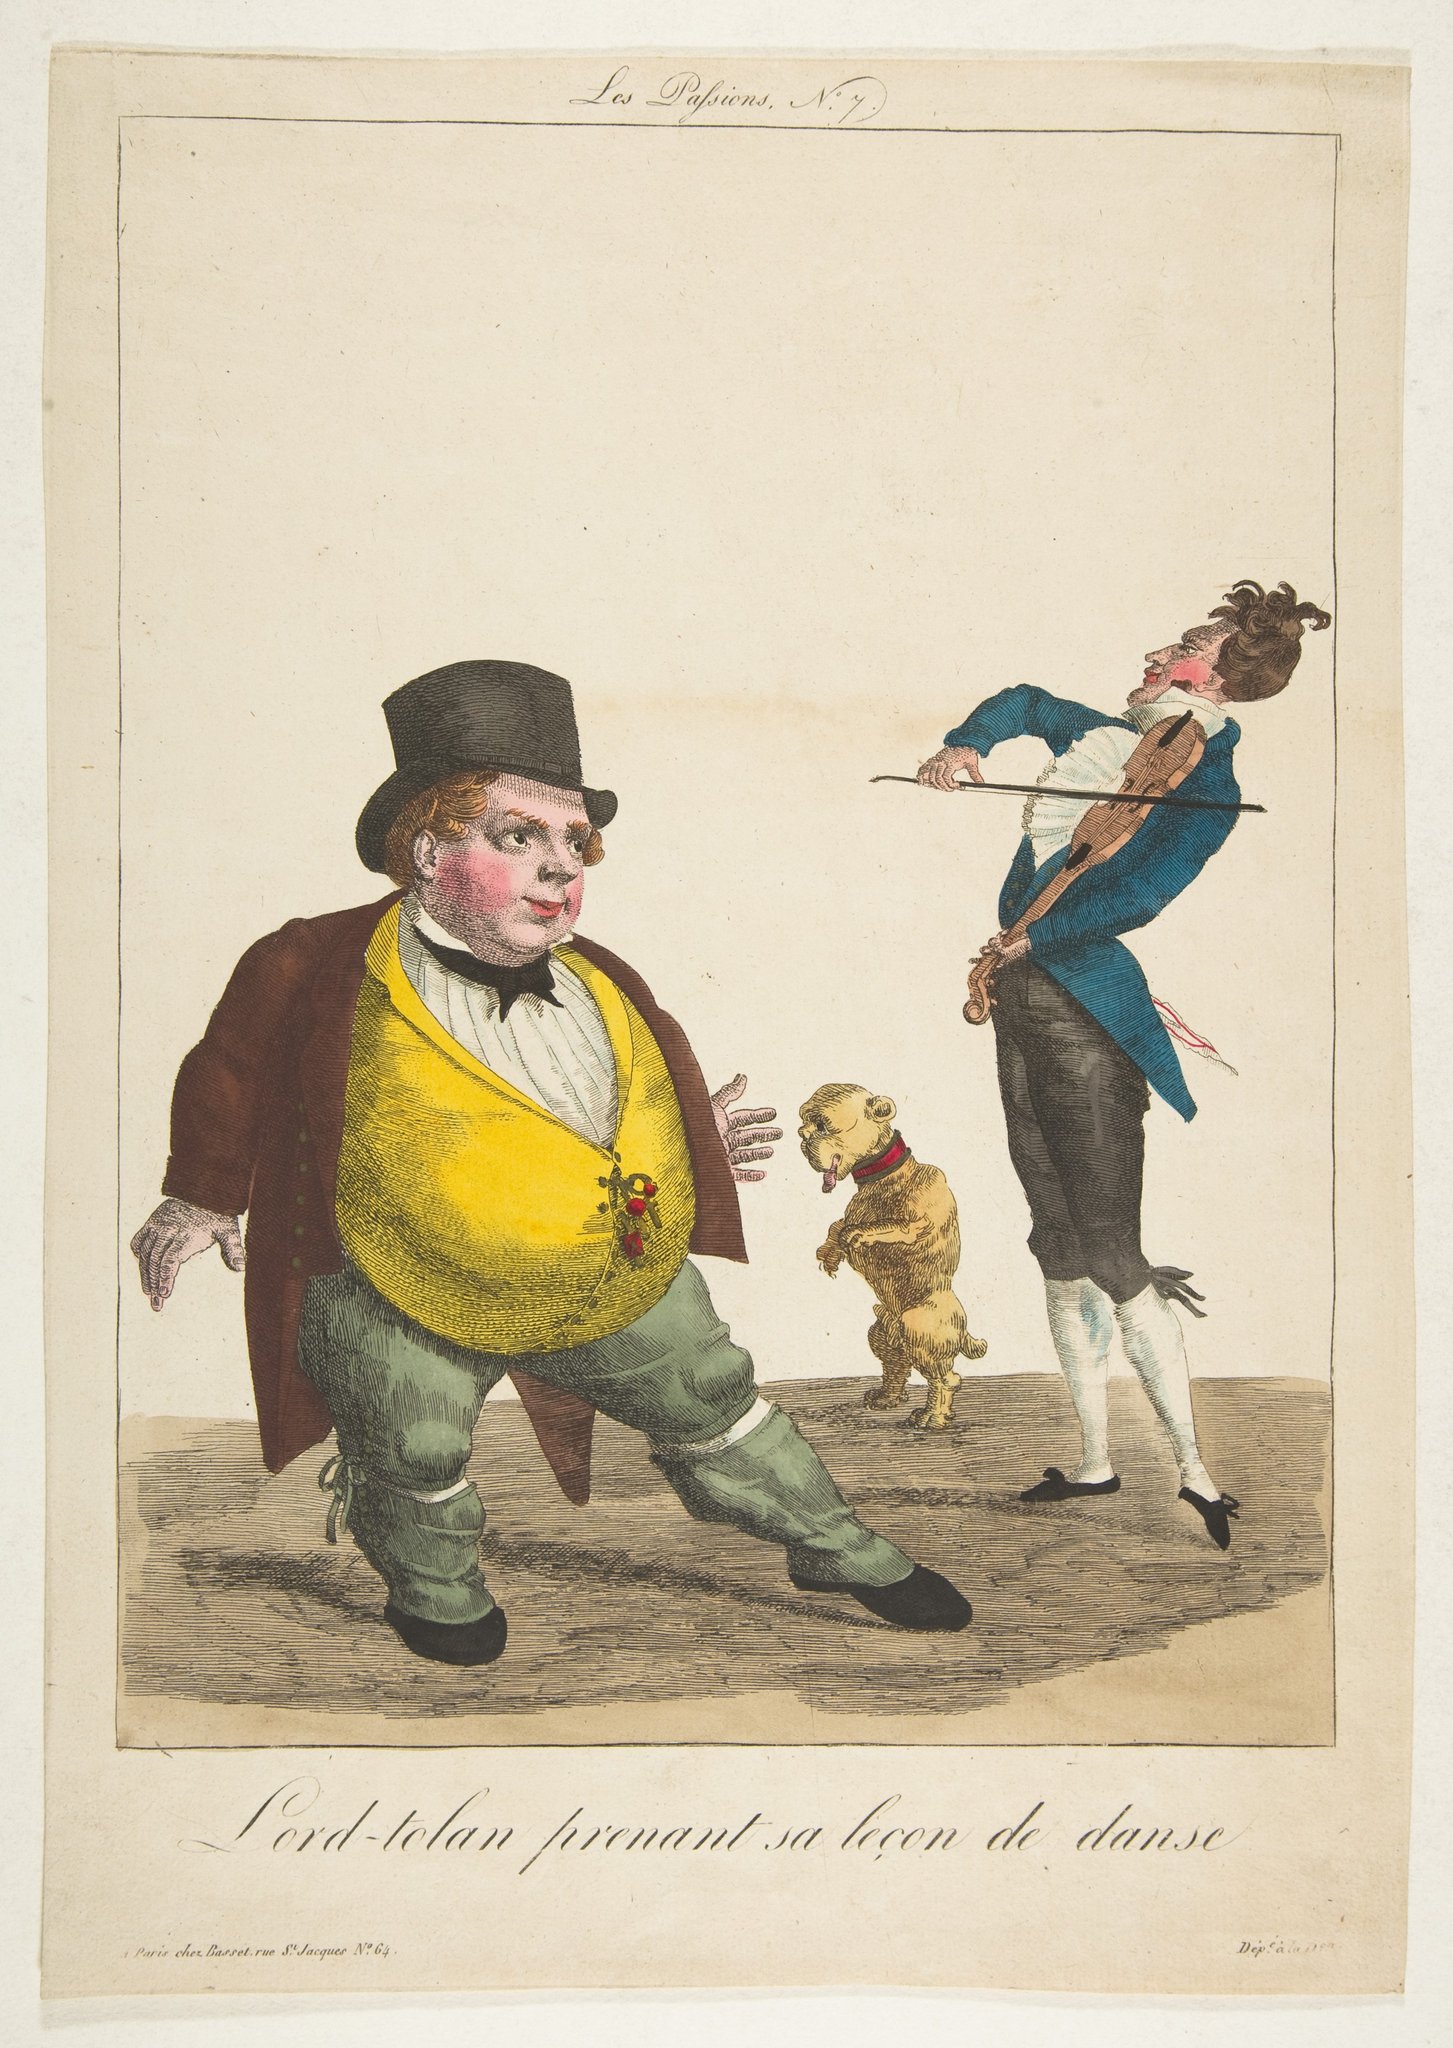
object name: print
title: Lord-tolan prenant sa leçon de dance, La Passions, No. 7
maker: basset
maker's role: publisher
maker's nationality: french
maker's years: 1785-1819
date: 1801-1900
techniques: etching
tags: men,dancing,music,violins,dogs